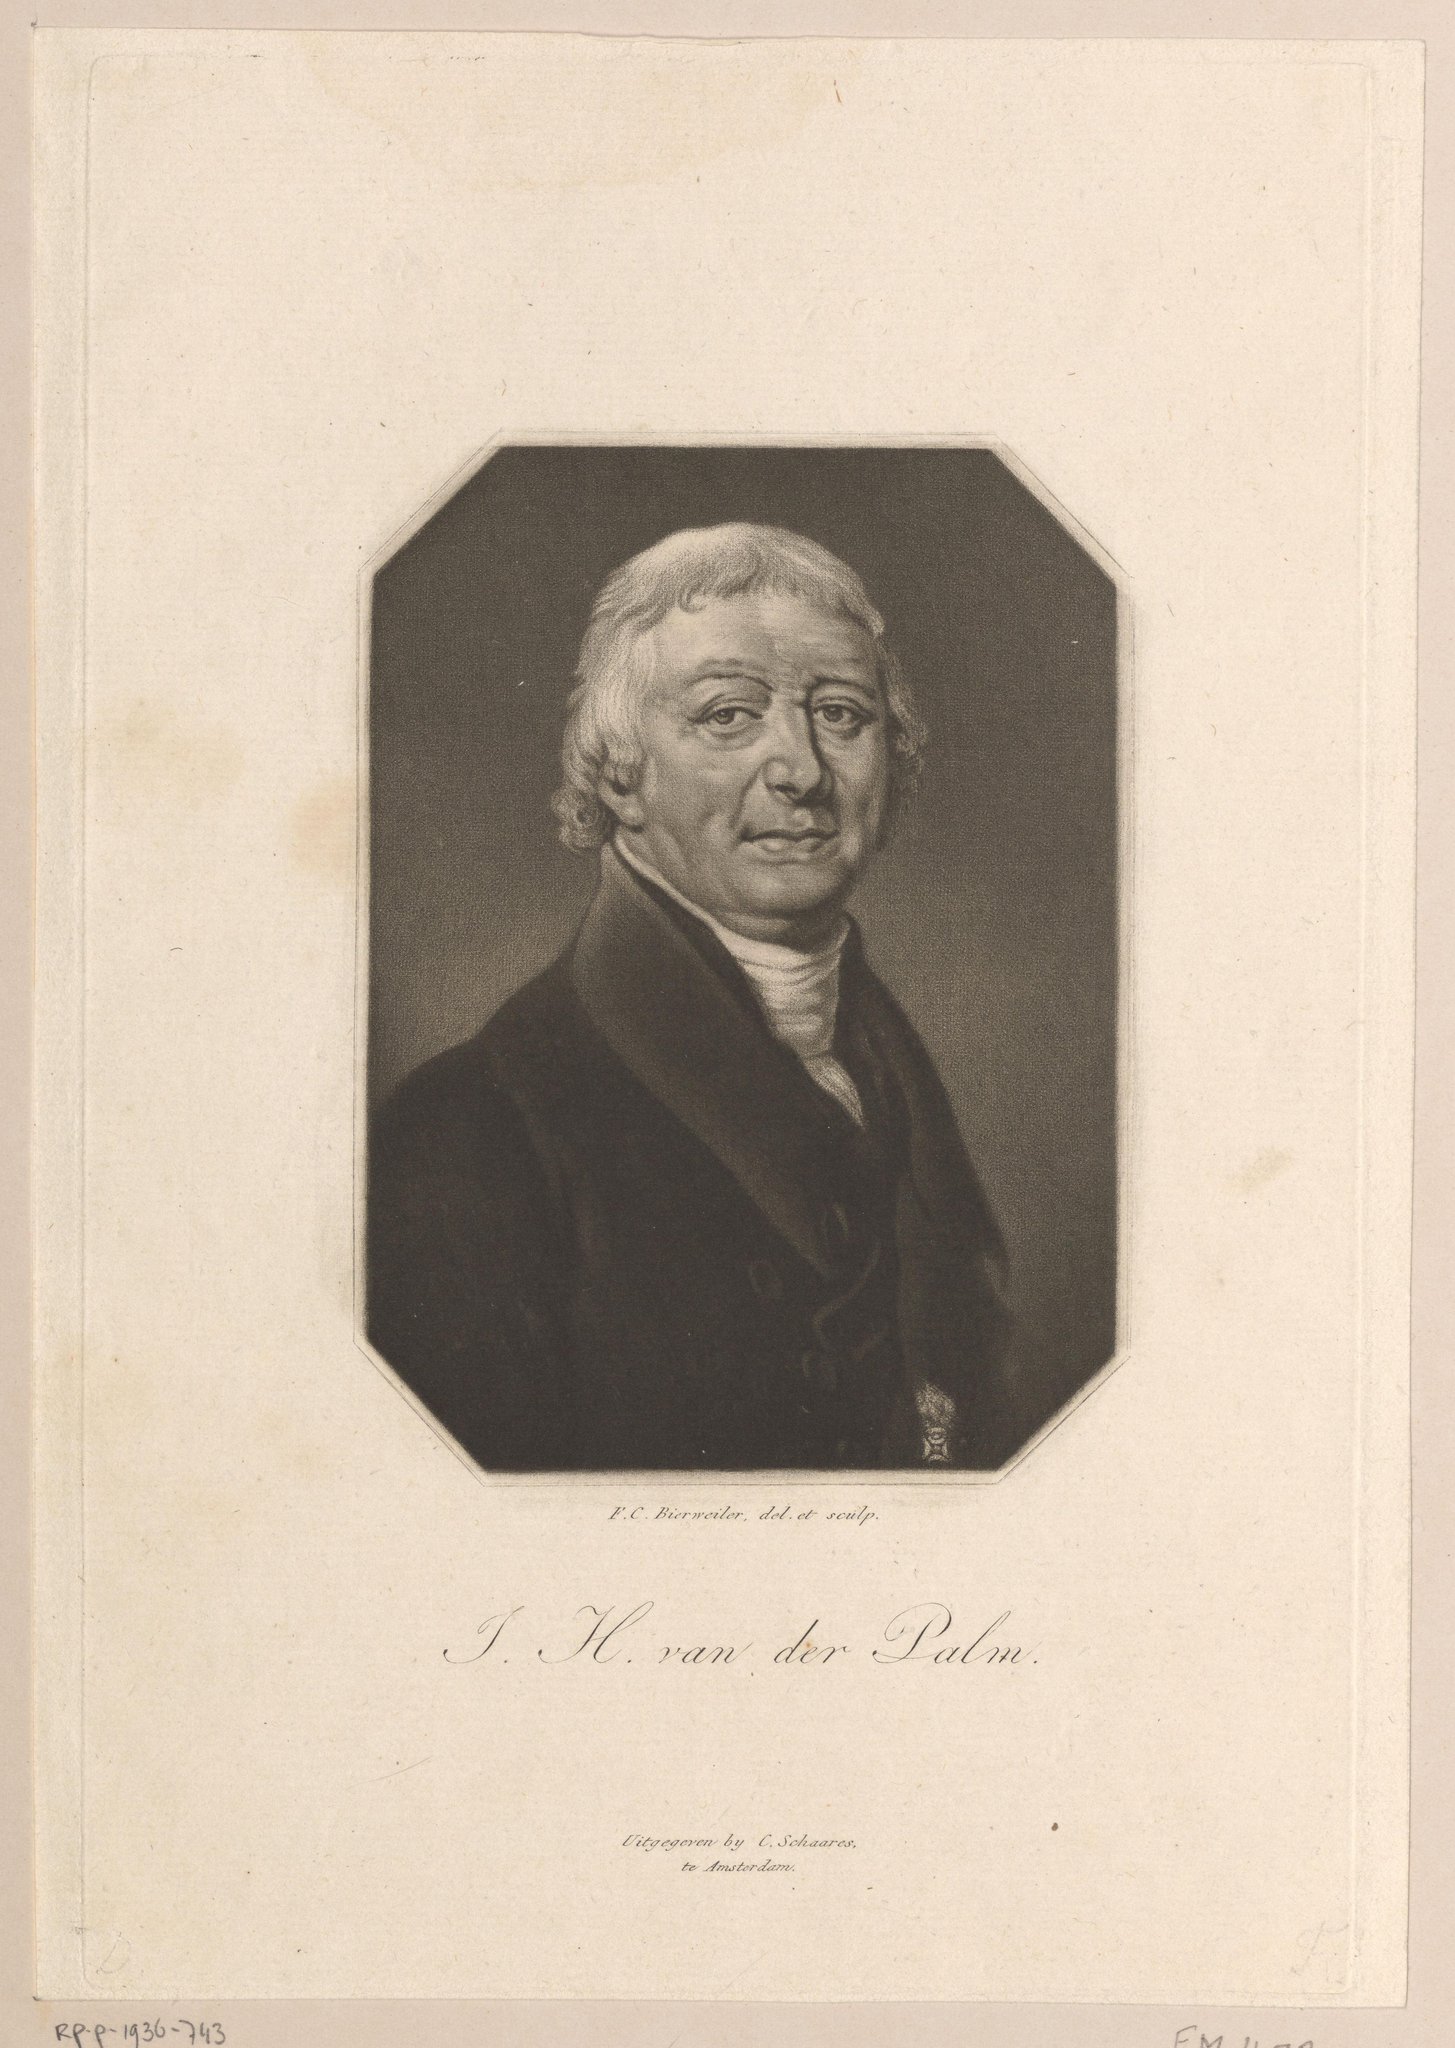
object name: print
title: Portret van Johannes Hendricus van der Palm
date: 1826-1830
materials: paper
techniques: engraving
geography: amsterdam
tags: leiden, johannes hendricus van der palm, adult man, historical persons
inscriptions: collector's mark: Lugt 2760, collector's mark: Lugt 2228